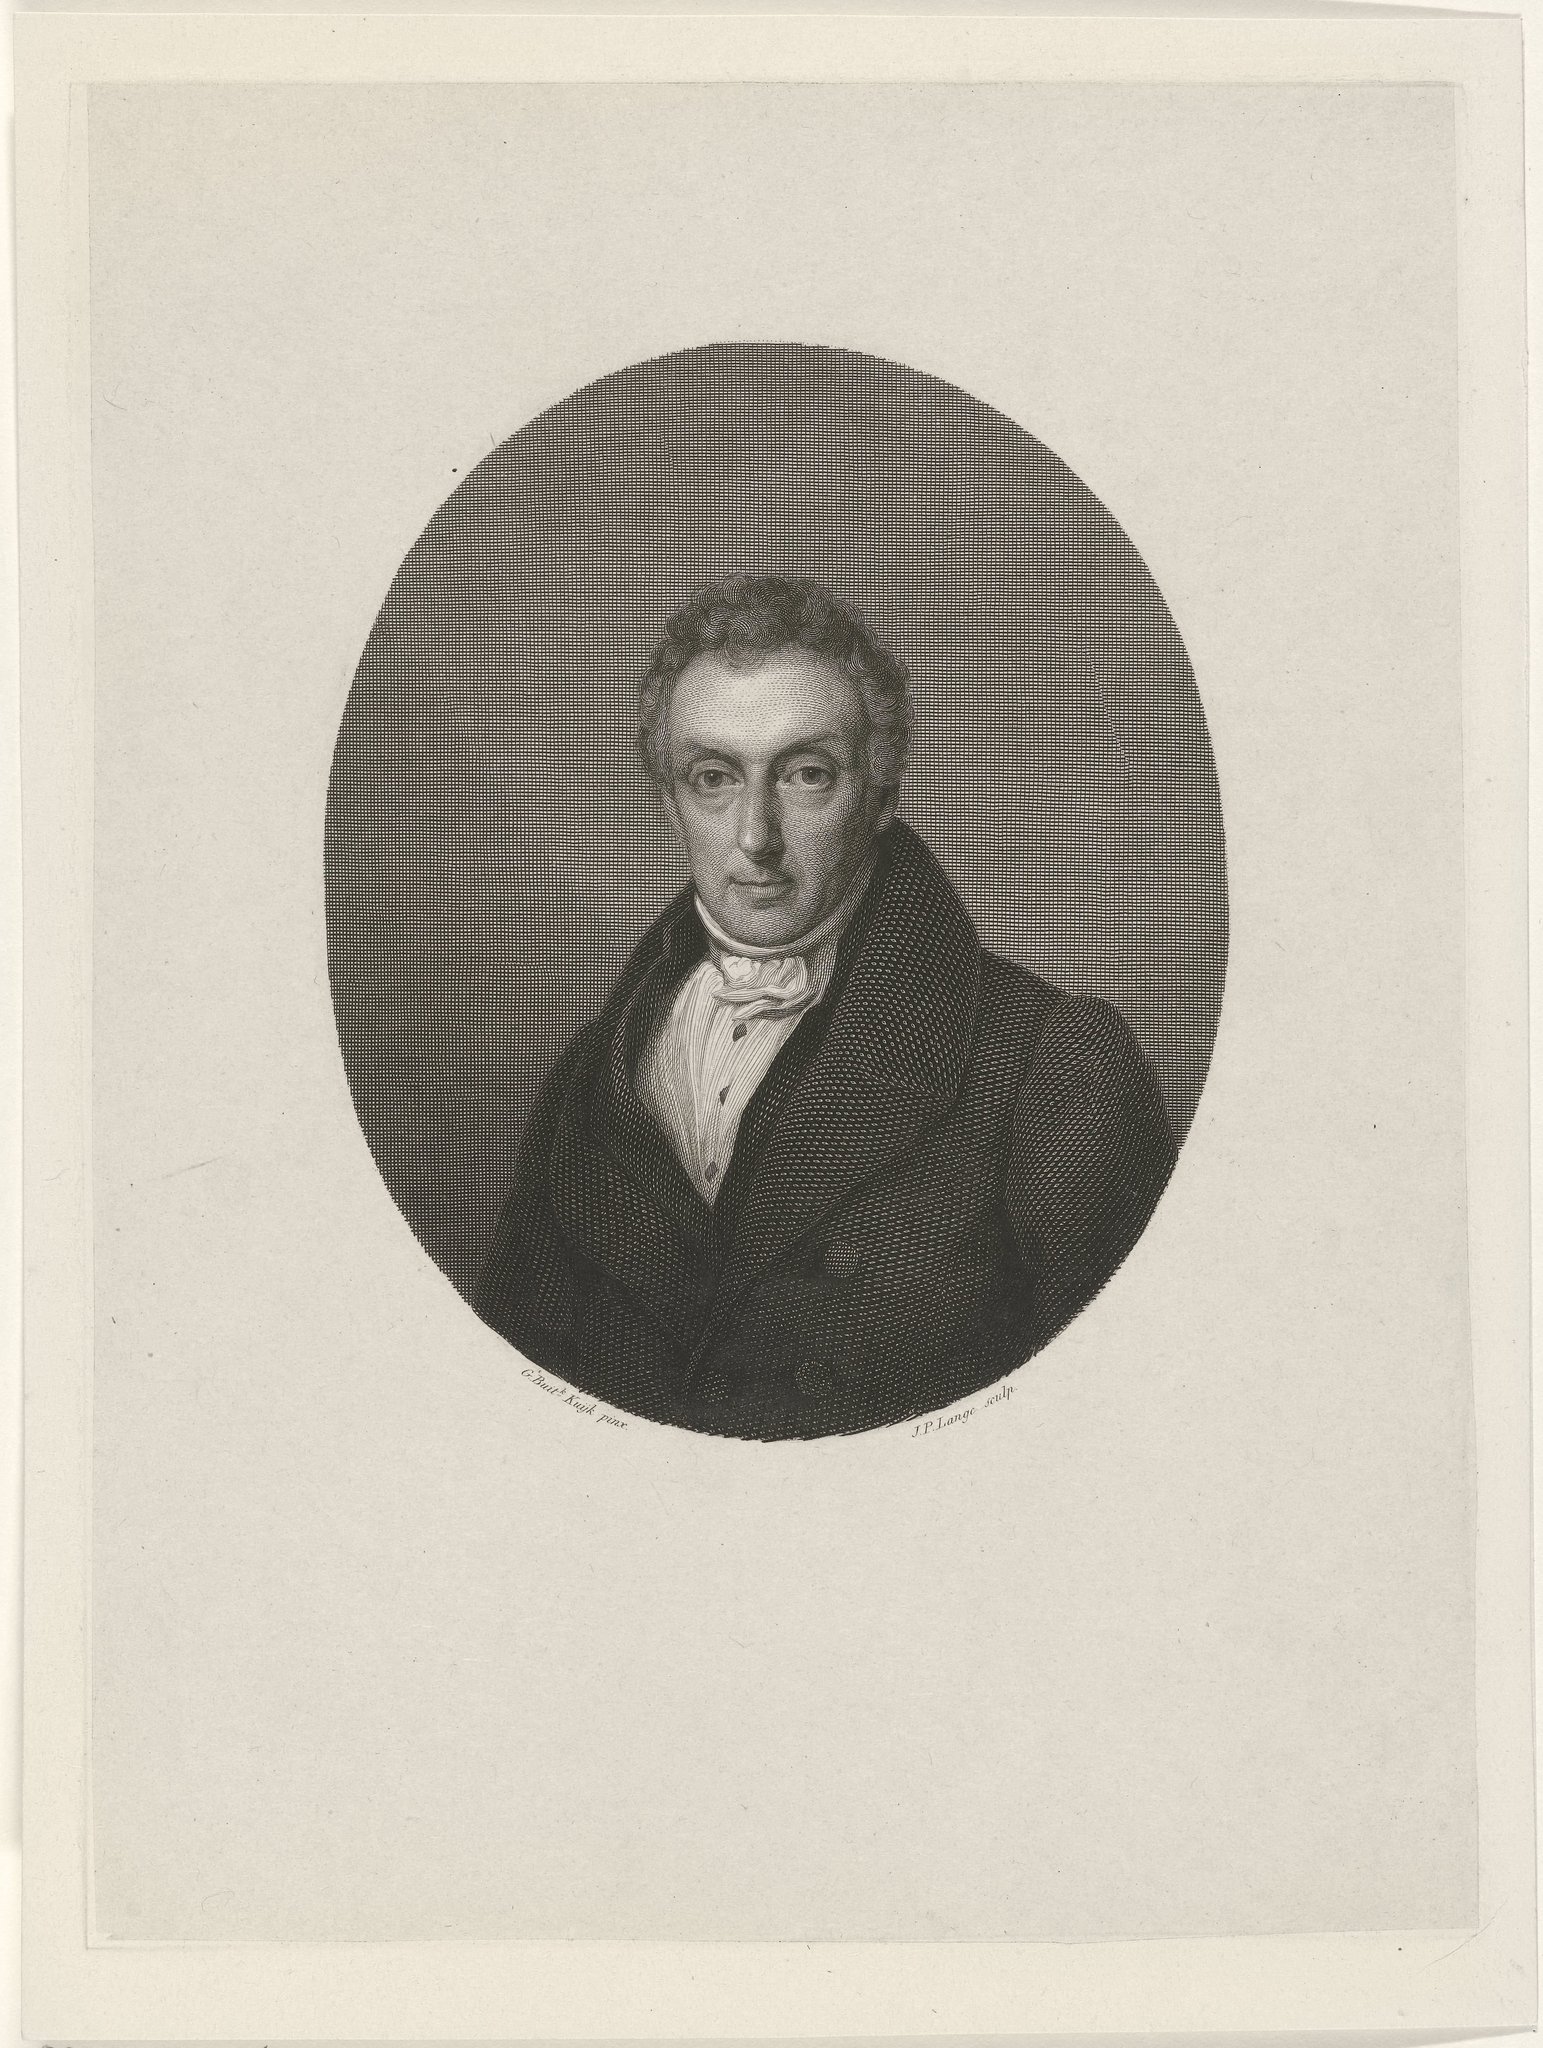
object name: print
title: Portret van Anthonij Moll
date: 1820-1849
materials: paper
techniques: engraving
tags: arnhem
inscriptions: collector's mark: Lugt 2228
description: Portretbuste in ovaal naar links van Anthonij Moll, arts en schrijver.